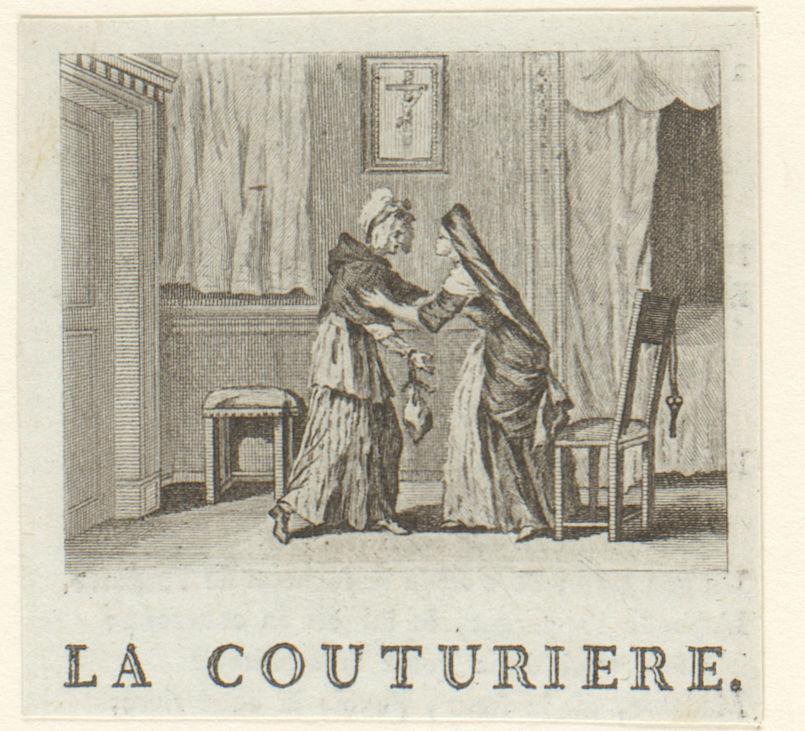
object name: book illustration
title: Twee vrouwen in een interieur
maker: Anonymous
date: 1763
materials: paper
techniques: engraving, etching, letterpress printing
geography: france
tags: adult woman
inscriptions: collector's mark: Lugt 2228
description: Mogelijk prent uit: Grecourt, Jean Baptiste Joseph Willart de. Oeuvres diverses de M. de Grécourt, nouvelle édition, augmentée d'un grand nombre de pièces, revus sur les originales et du Philotanis. Amsterdam: s.n., 1763.